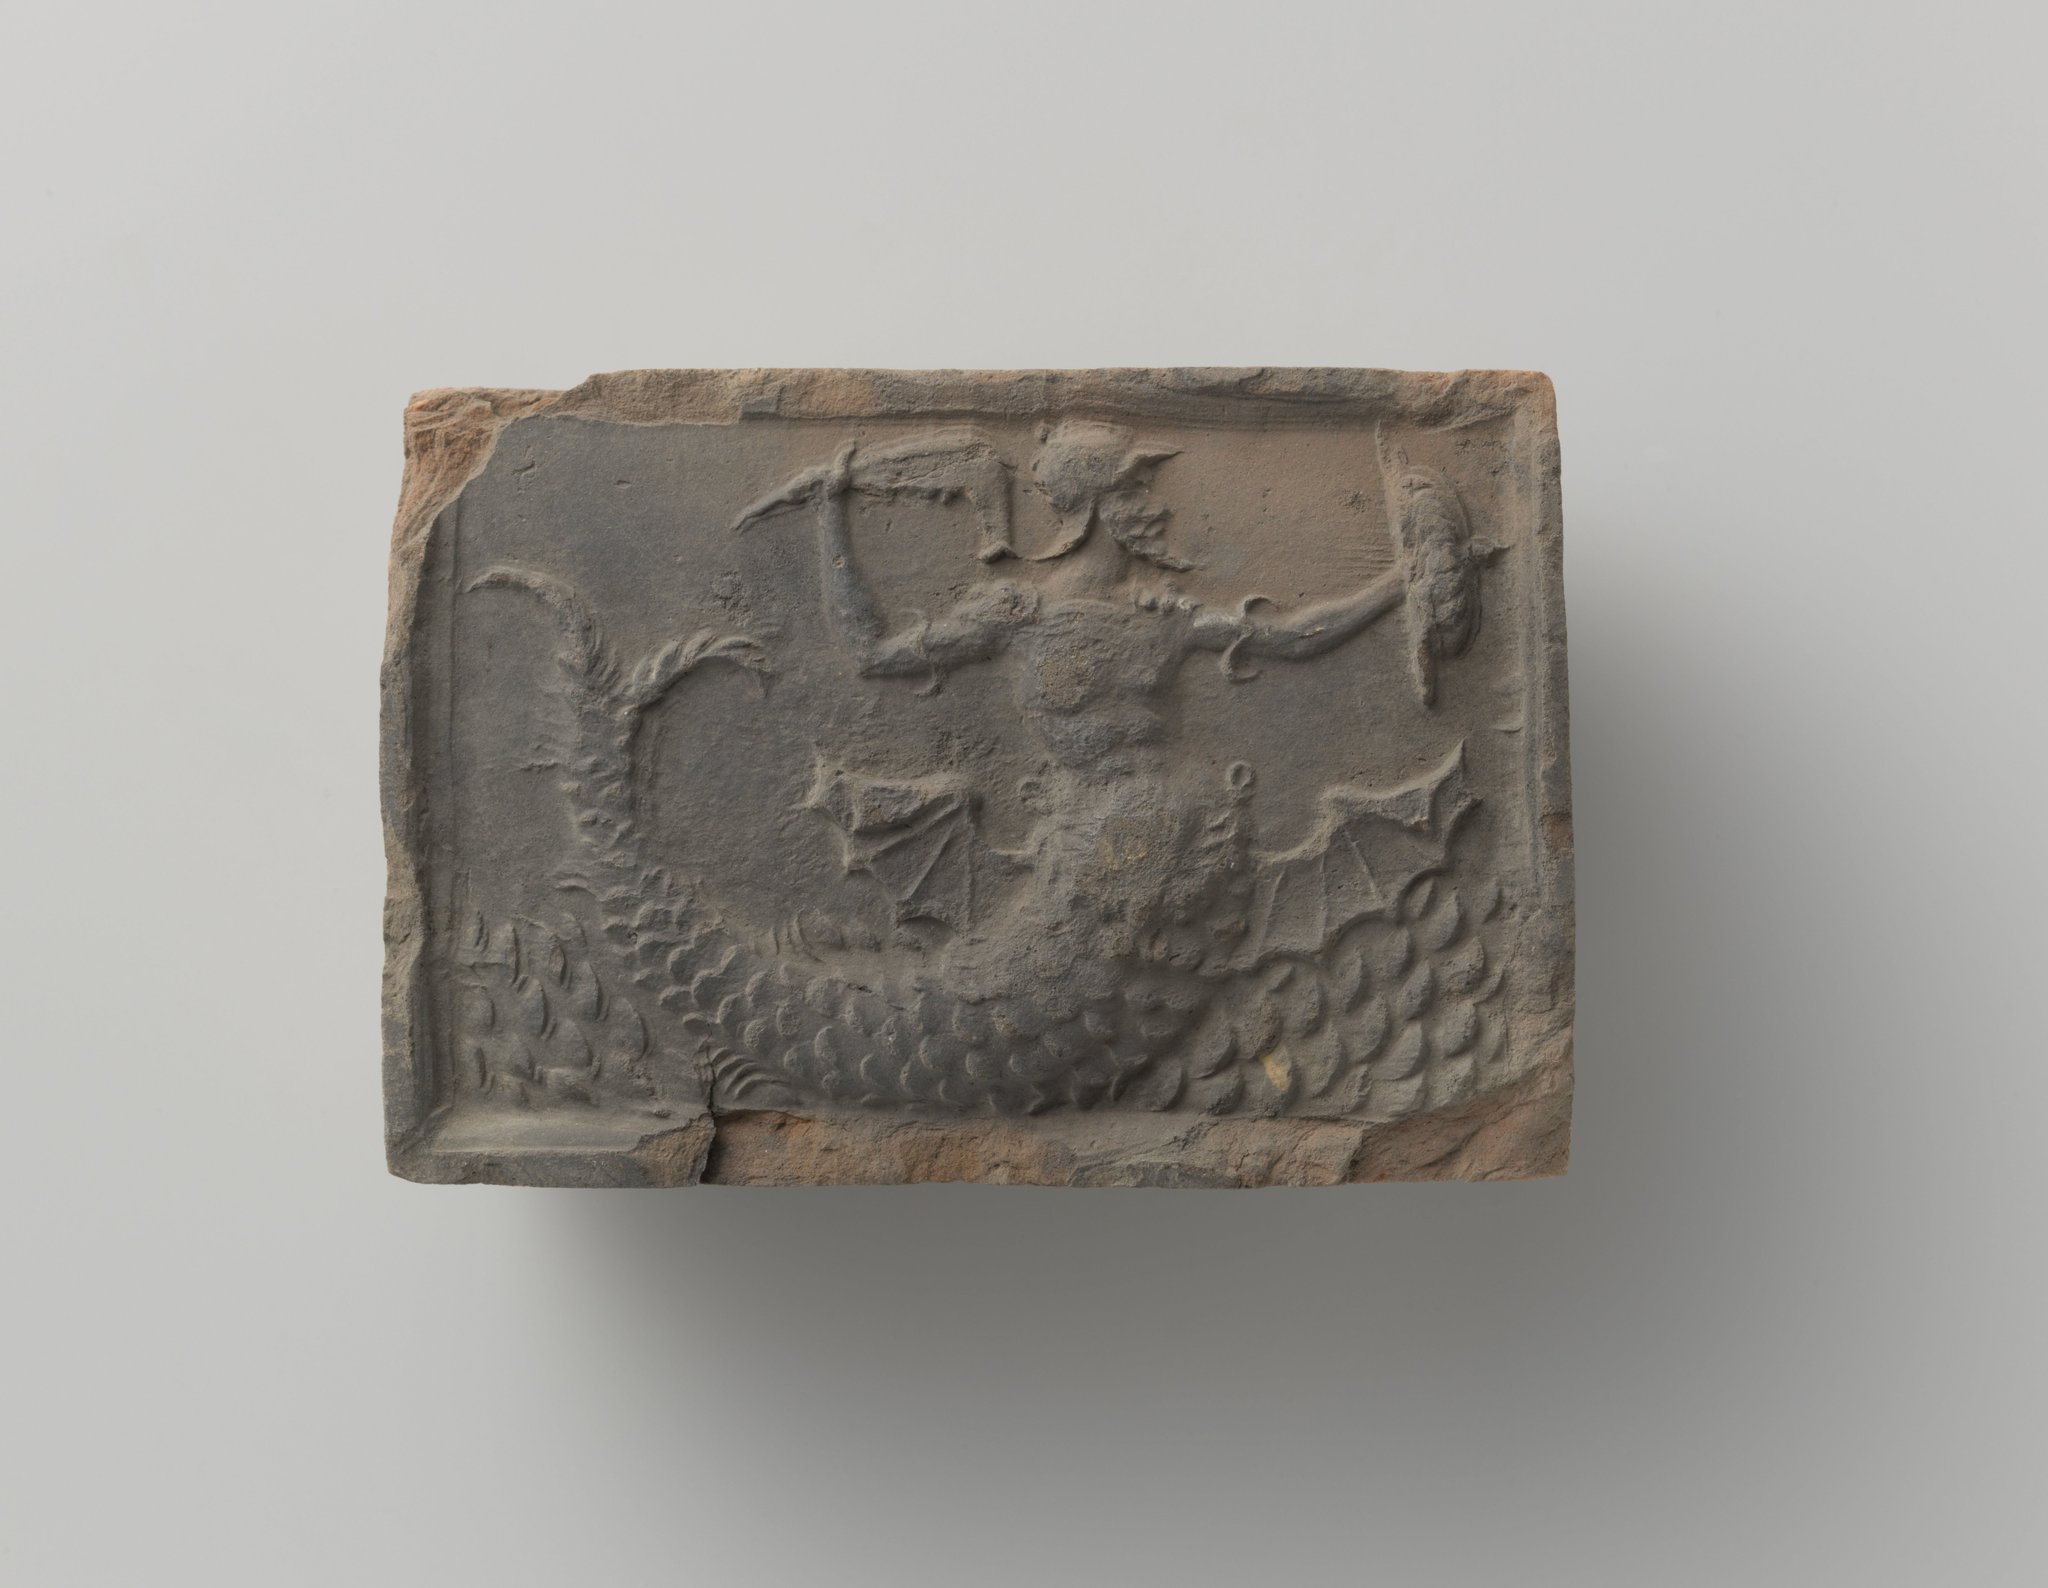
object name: architectural element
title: Haardsteen, half man, half vis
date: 1550-1599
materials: earthenware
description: haardsteen met een voorstelling van triton met in de ene hand een wapen en in de andere een rondas